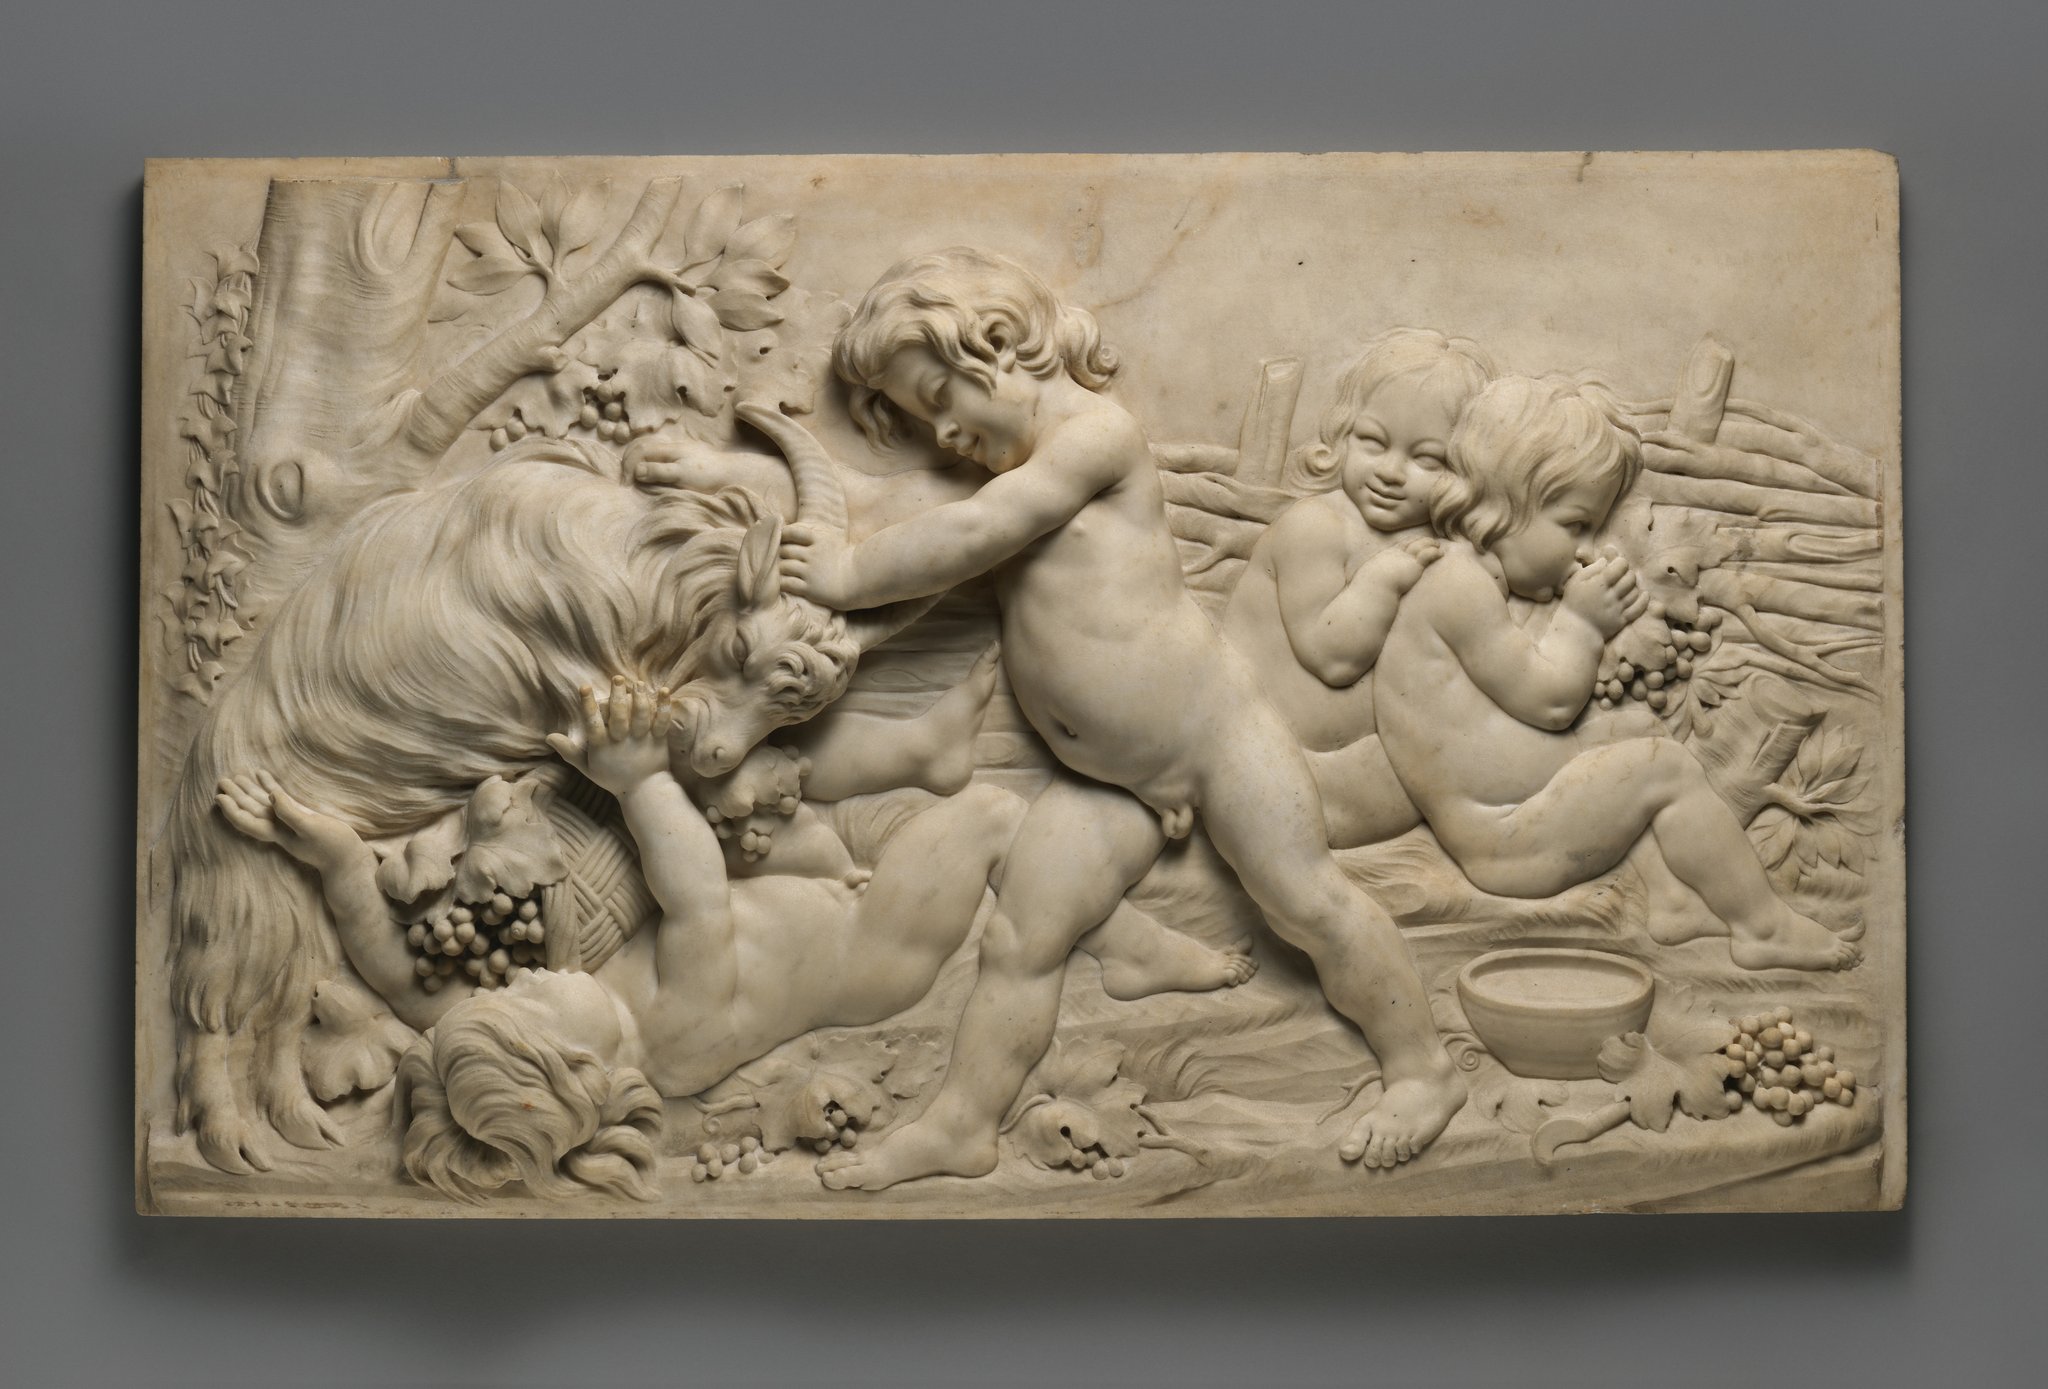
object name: relief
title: Autumn (one of a set of four)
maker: edme bouchardon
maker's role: artist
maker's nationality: french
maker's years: 1698-1762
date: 1734-1766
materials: marble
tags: grapes,children,goats,autumn